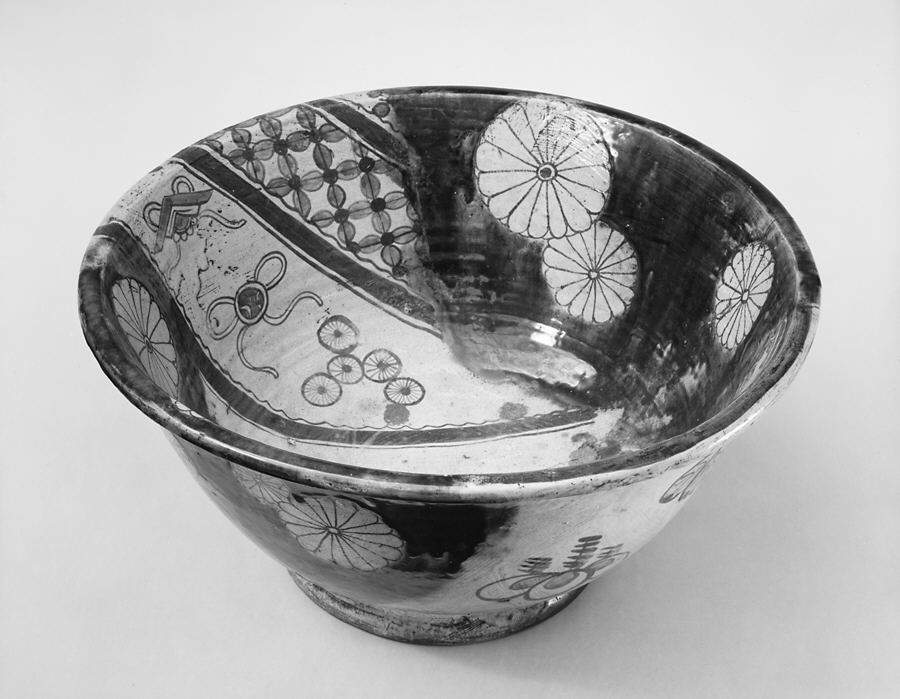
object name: bowl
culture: japanese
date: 1801-1833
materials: stoneware